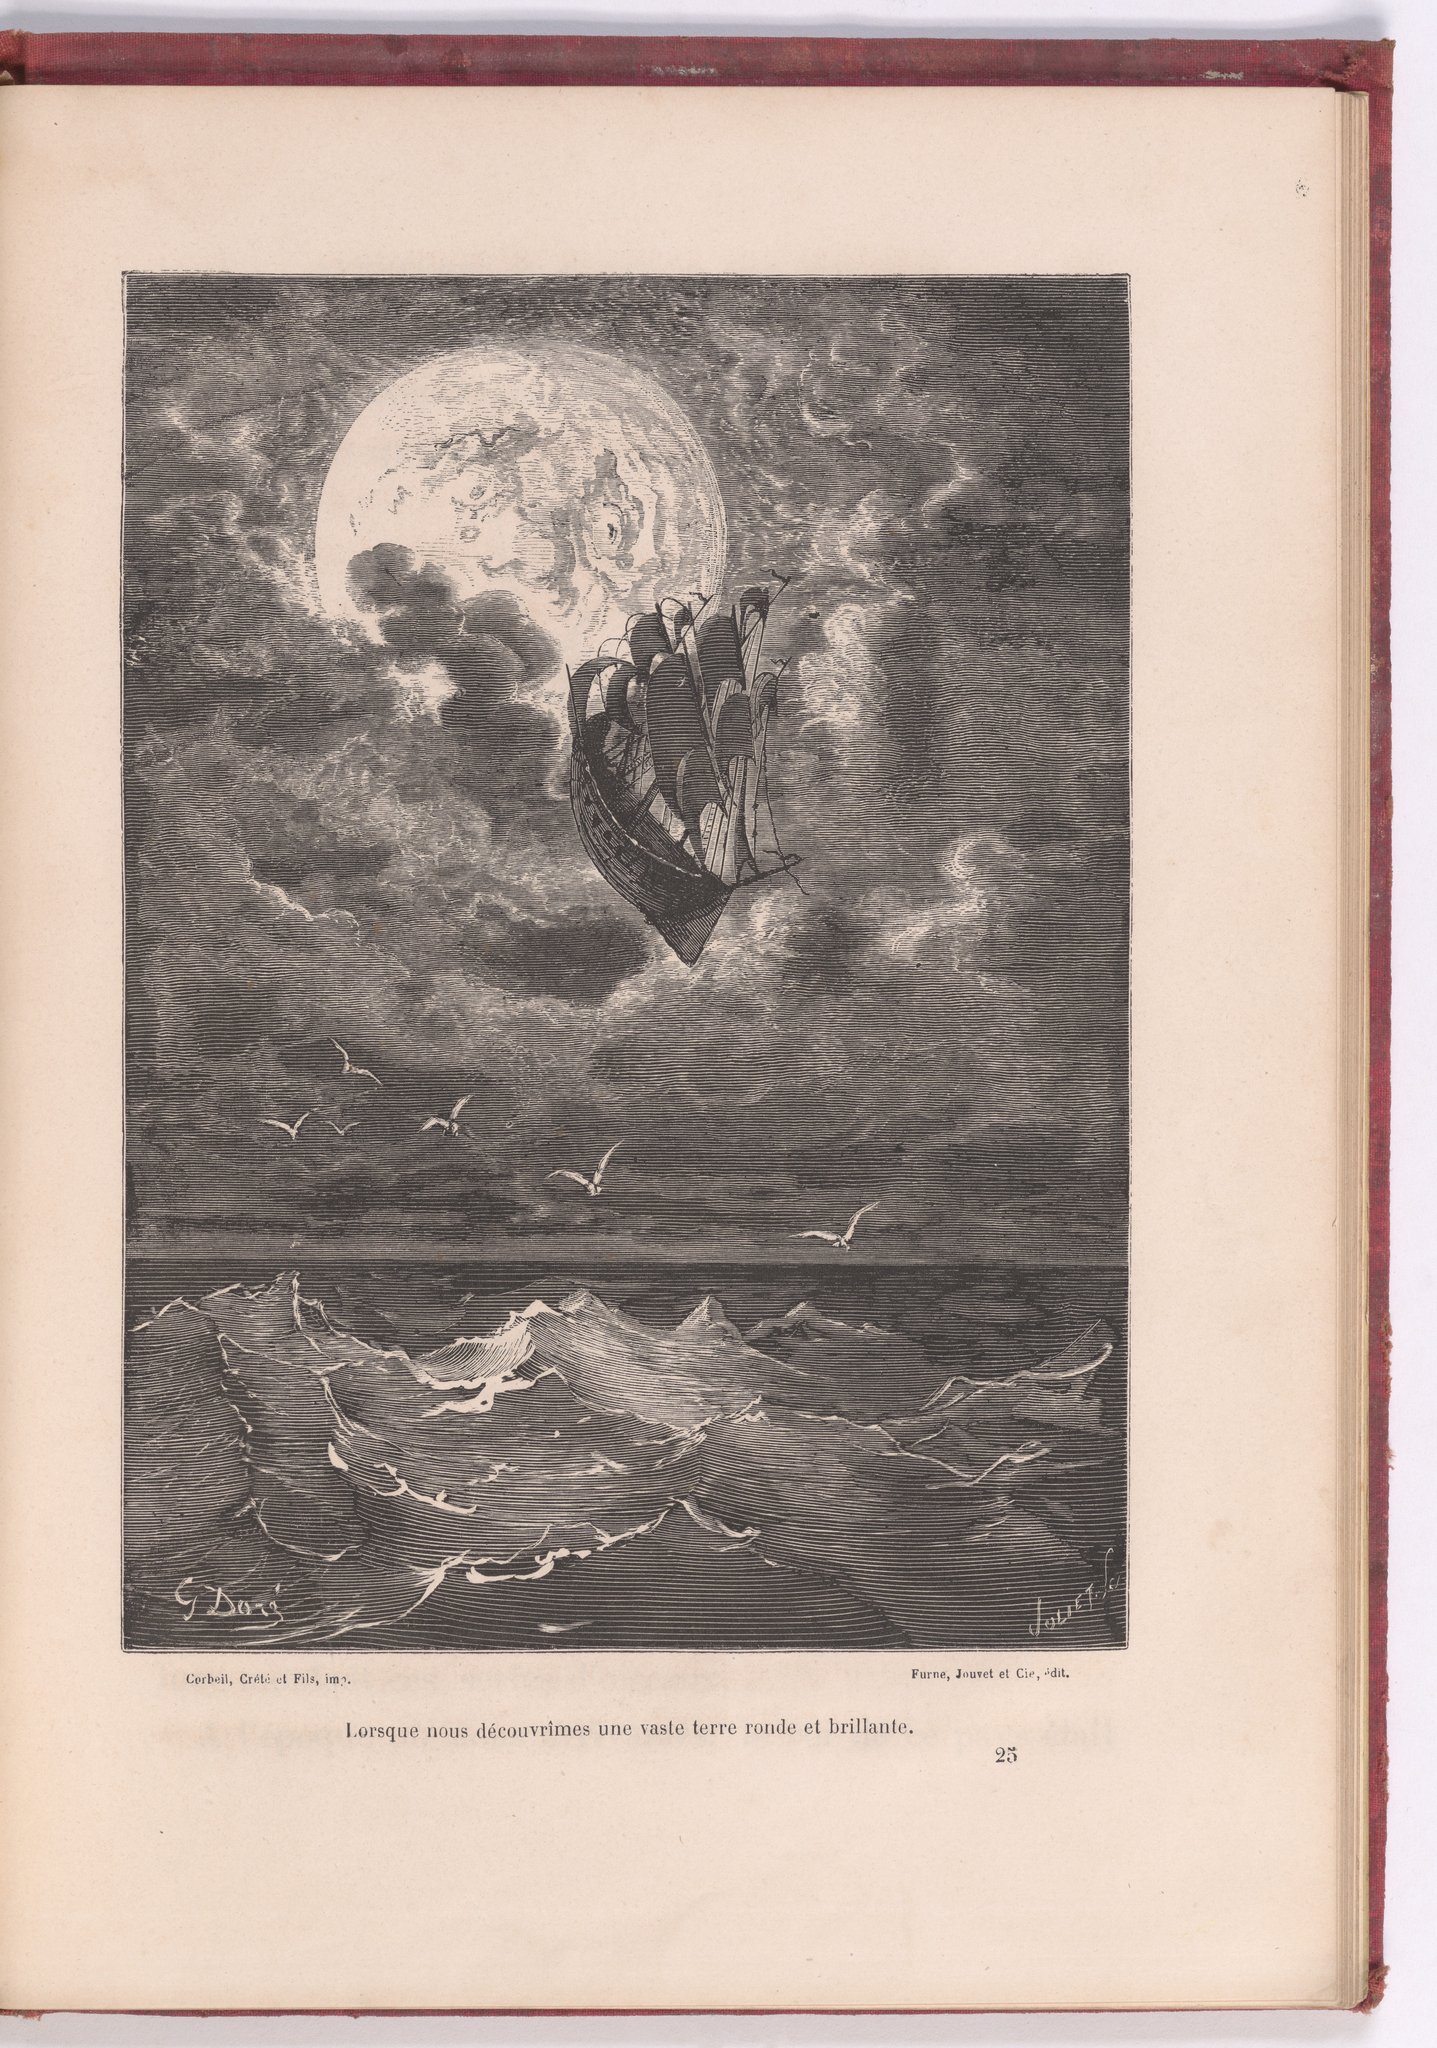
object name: book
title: Adventures du Baron Munchhausen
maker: adolf von gerlach, baron von münchhausen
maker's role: author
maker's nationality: german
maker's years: 1688-1770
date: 1866